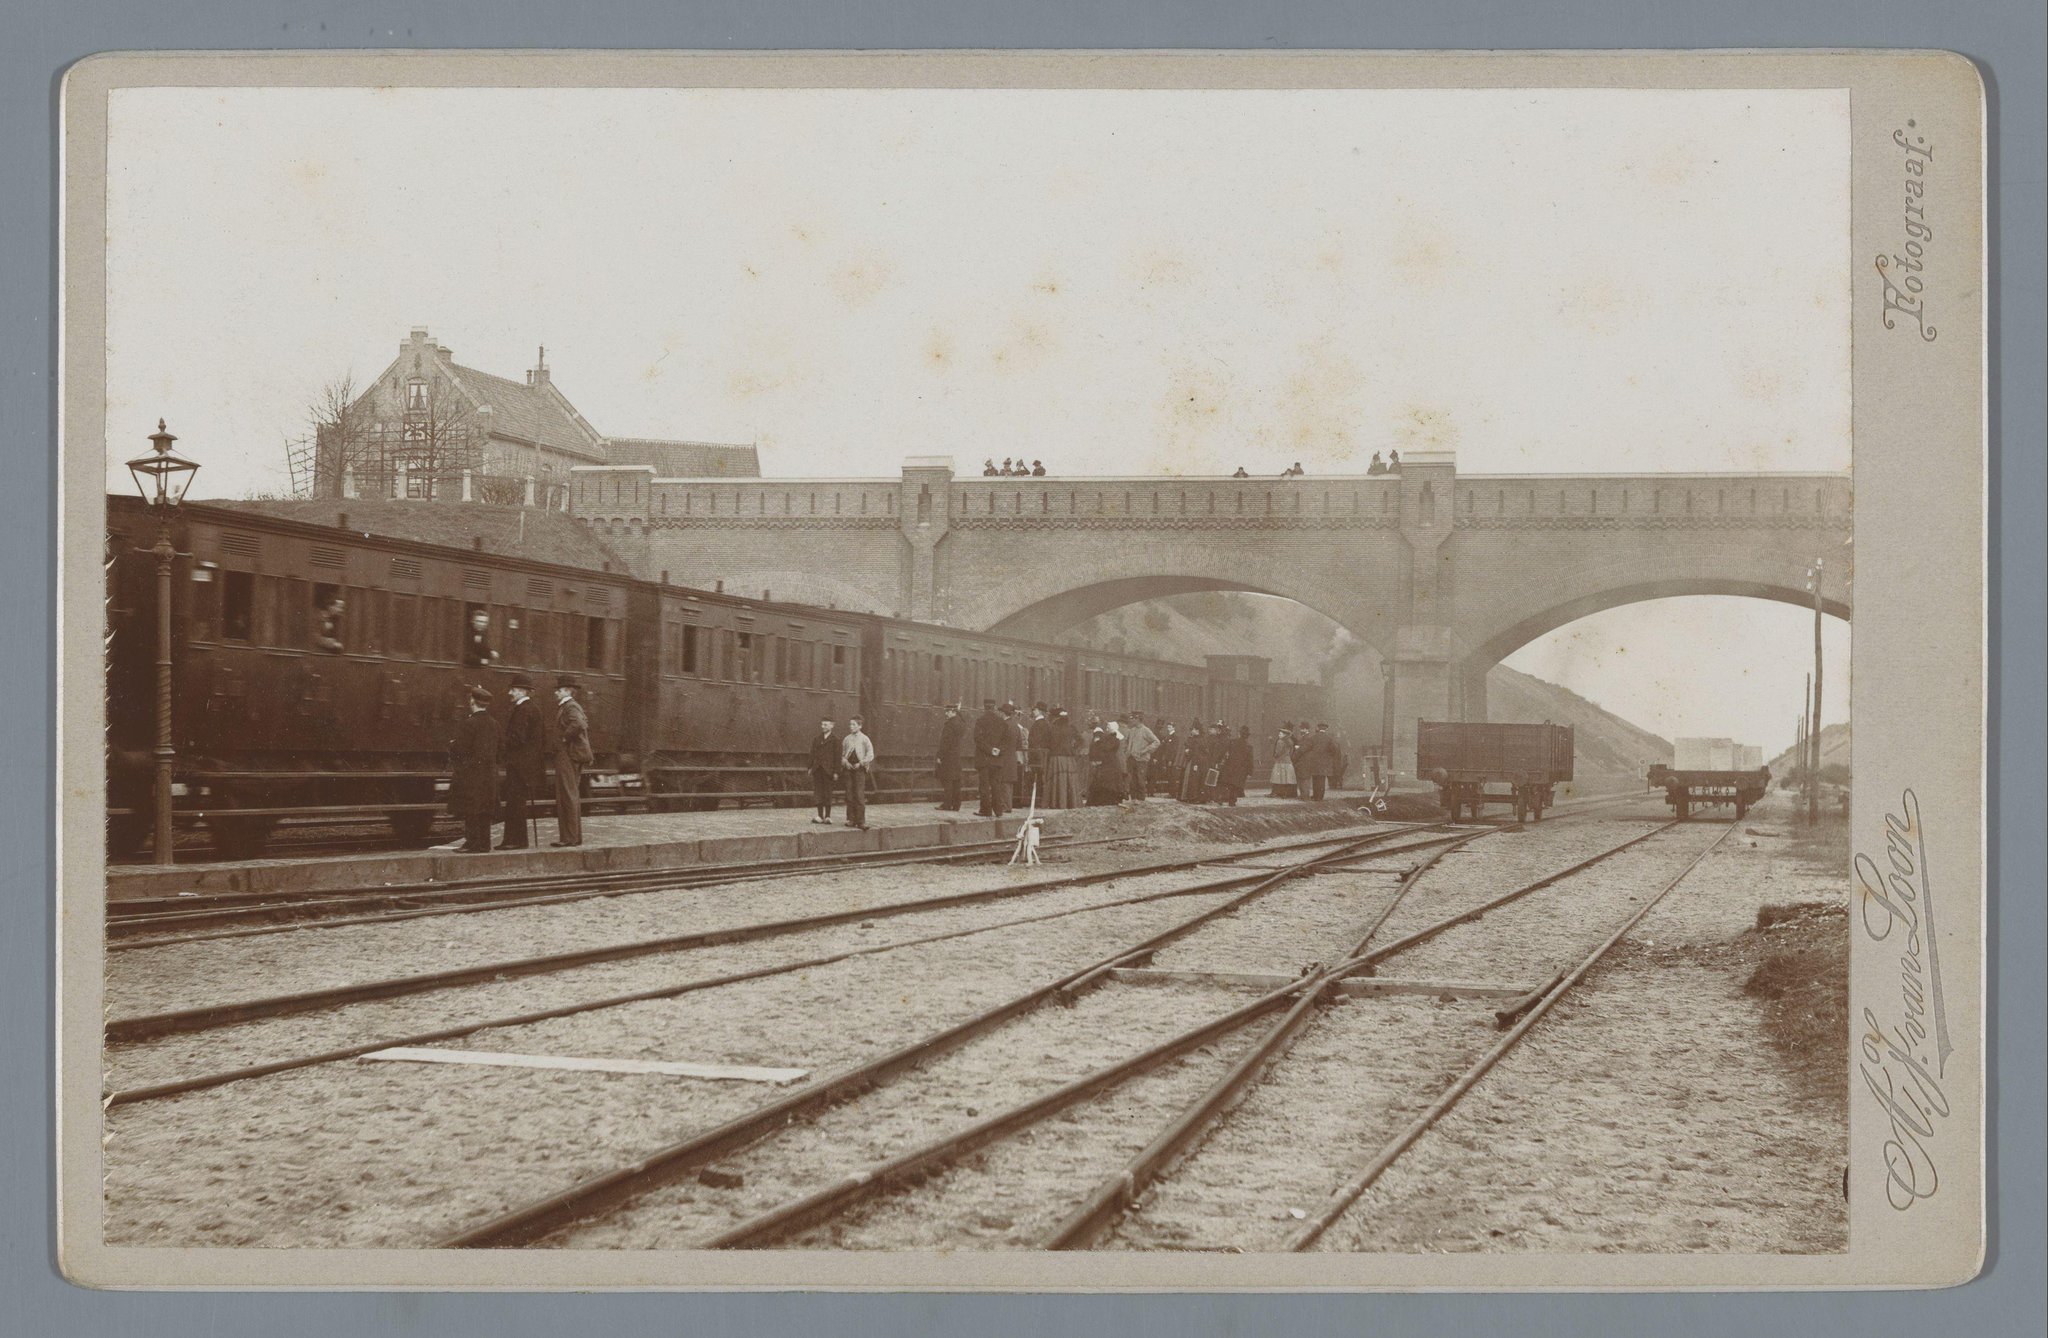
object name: photograph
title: Gezicht op het station te Rhenen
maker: a.j. van loon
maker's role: fotograaf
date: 1880-1940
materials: paper, cardboard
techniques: collodion silver print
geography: rhenen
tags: passenger train, station; shelter (railway, tramway), rhenen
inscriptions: inscription: ‘Rhenen-Stationsterrein’